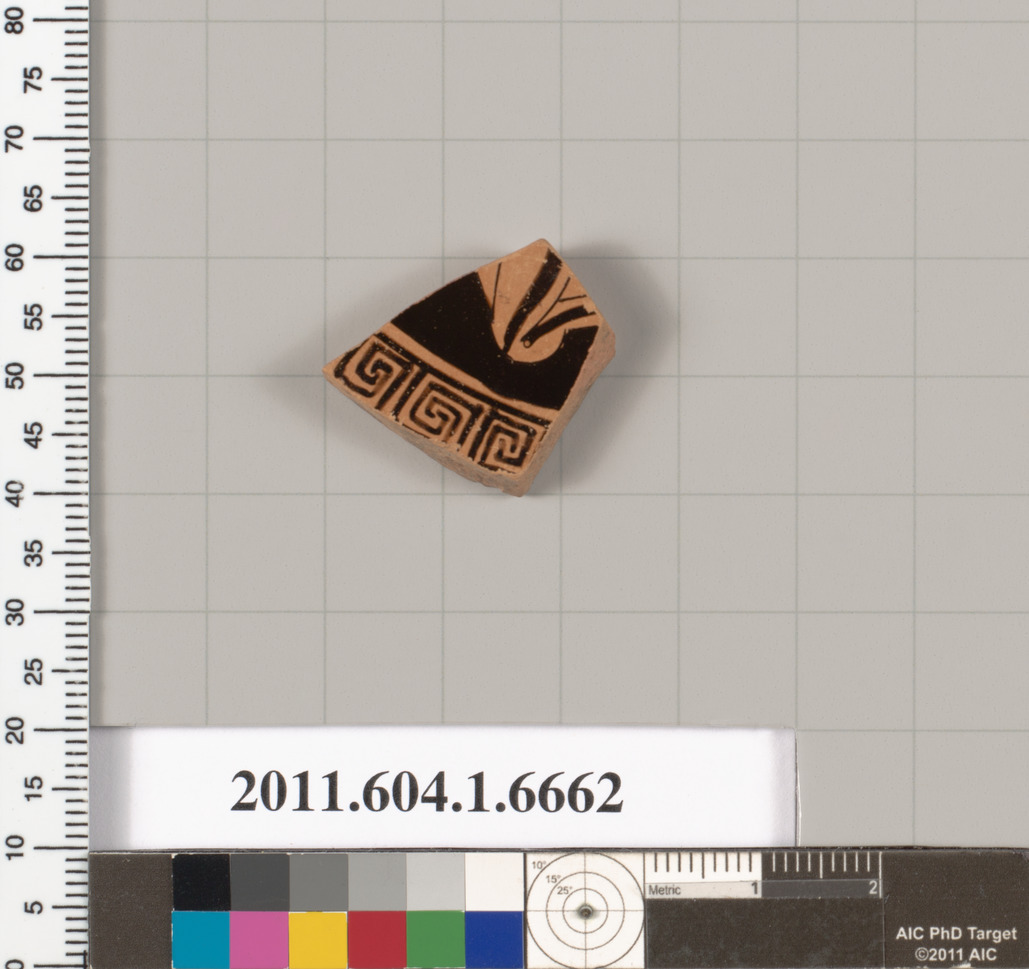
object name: kylix fragment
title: Terracotta fragment of a kylix (drinking cup)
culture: greek, attic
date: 490-470 BCE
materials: terracotta